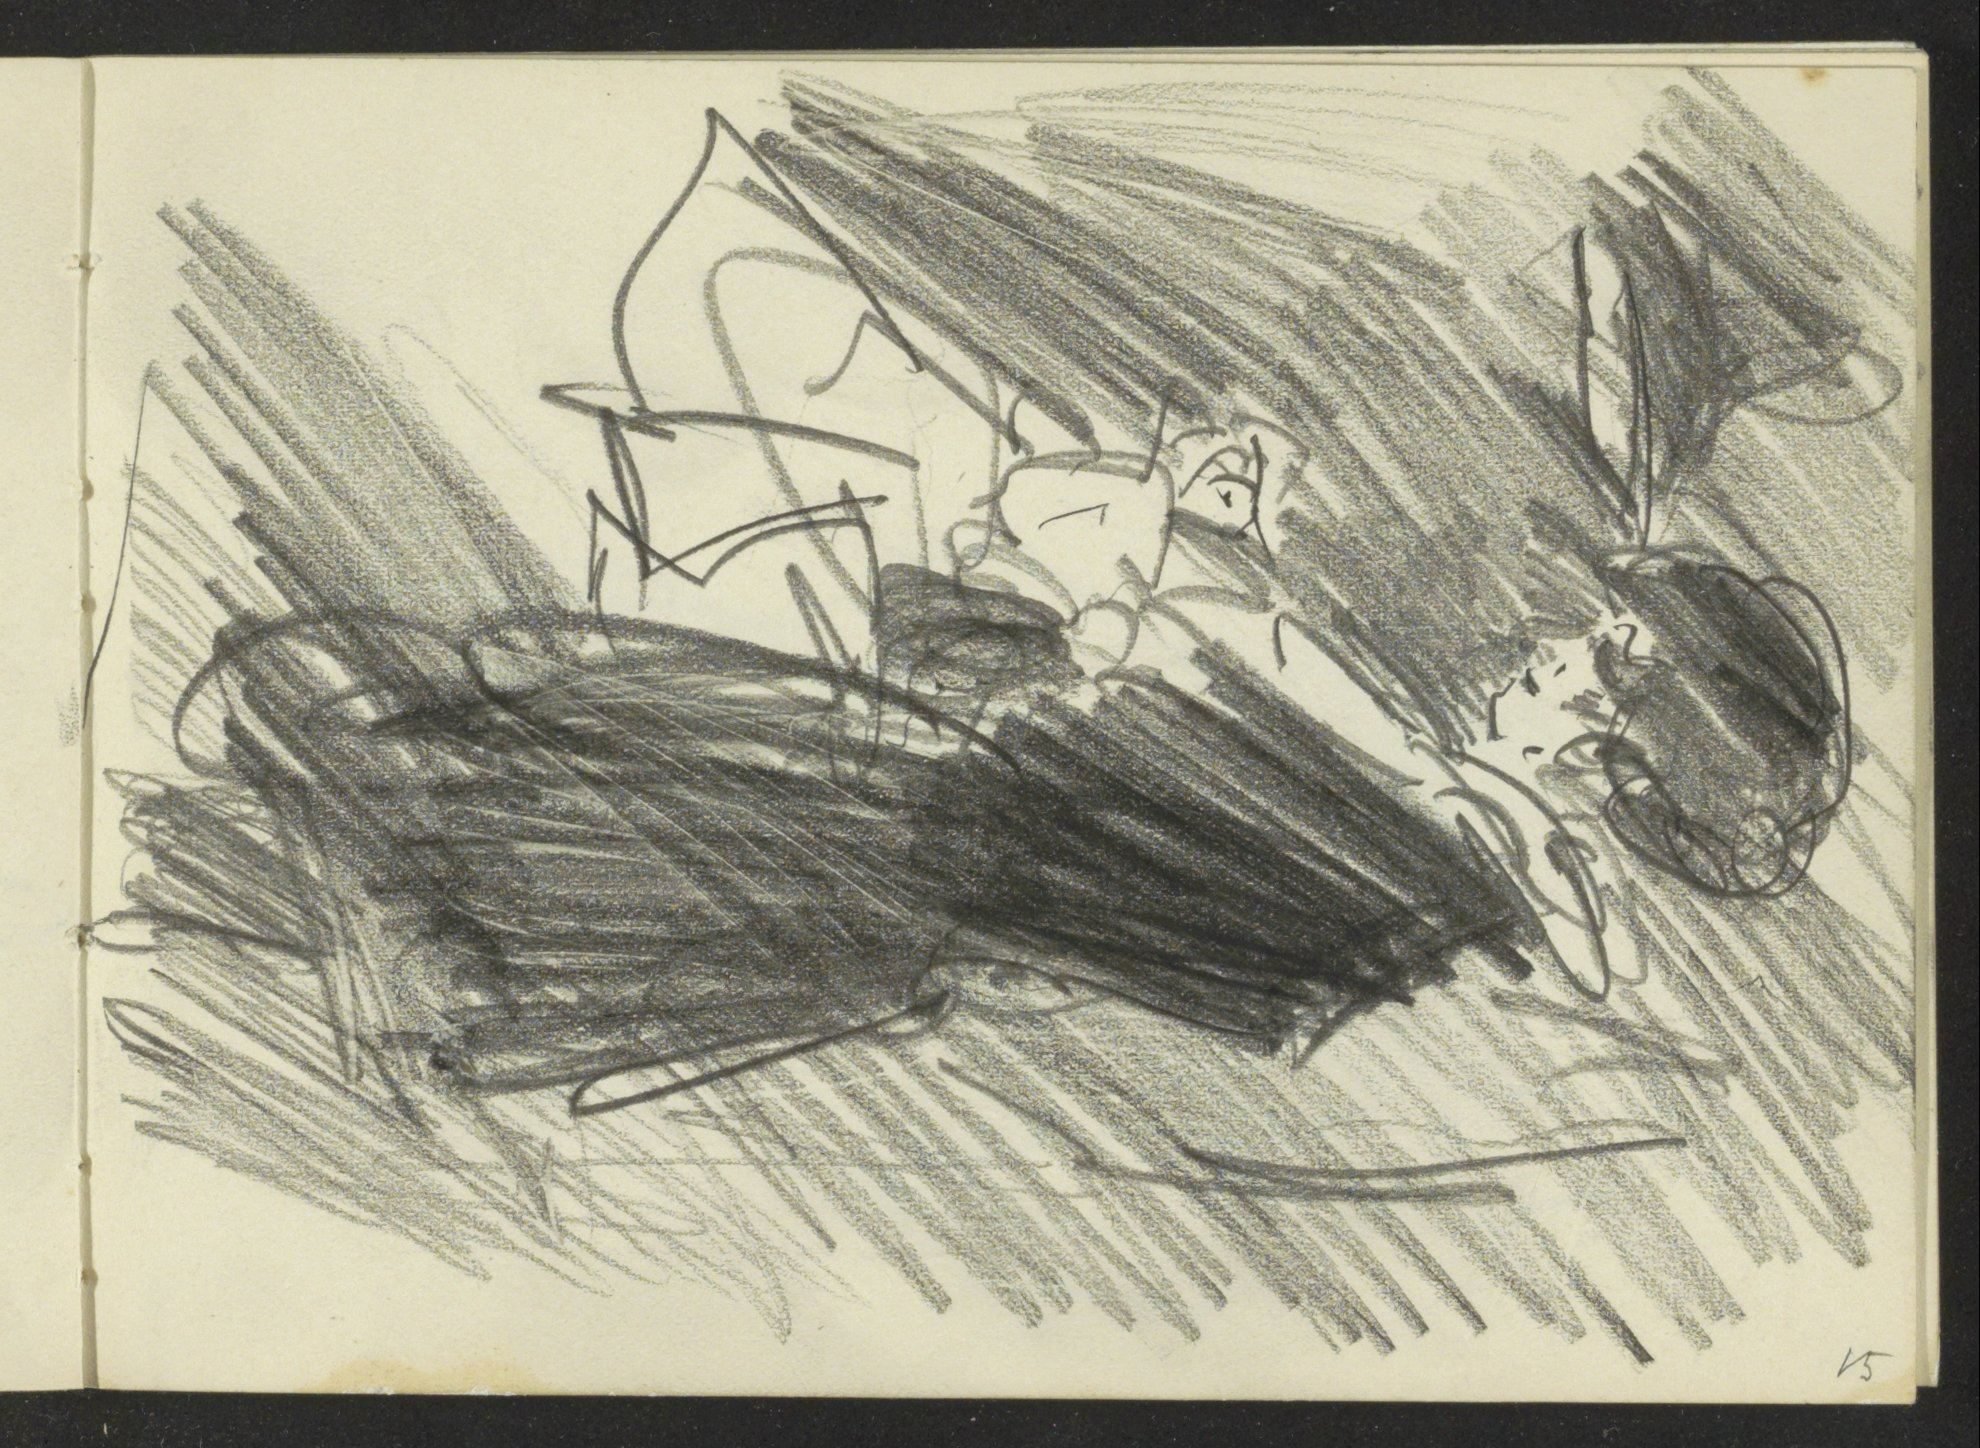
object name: sketchbook leaf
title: Staande vrouw, in profiel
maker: isaac israels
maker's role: draughtsman, painter, print maker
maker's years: 1865-1934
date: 1875-1934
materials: paper, pencil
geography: the hague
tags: adult woman (+ standing), lighting; lamps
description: Bij haar hoofd mogelijk een hanglamp. Op de achtergrond een tweede vrouw. Blad 15 recto uit schetsboek LXV met 27 bladen.